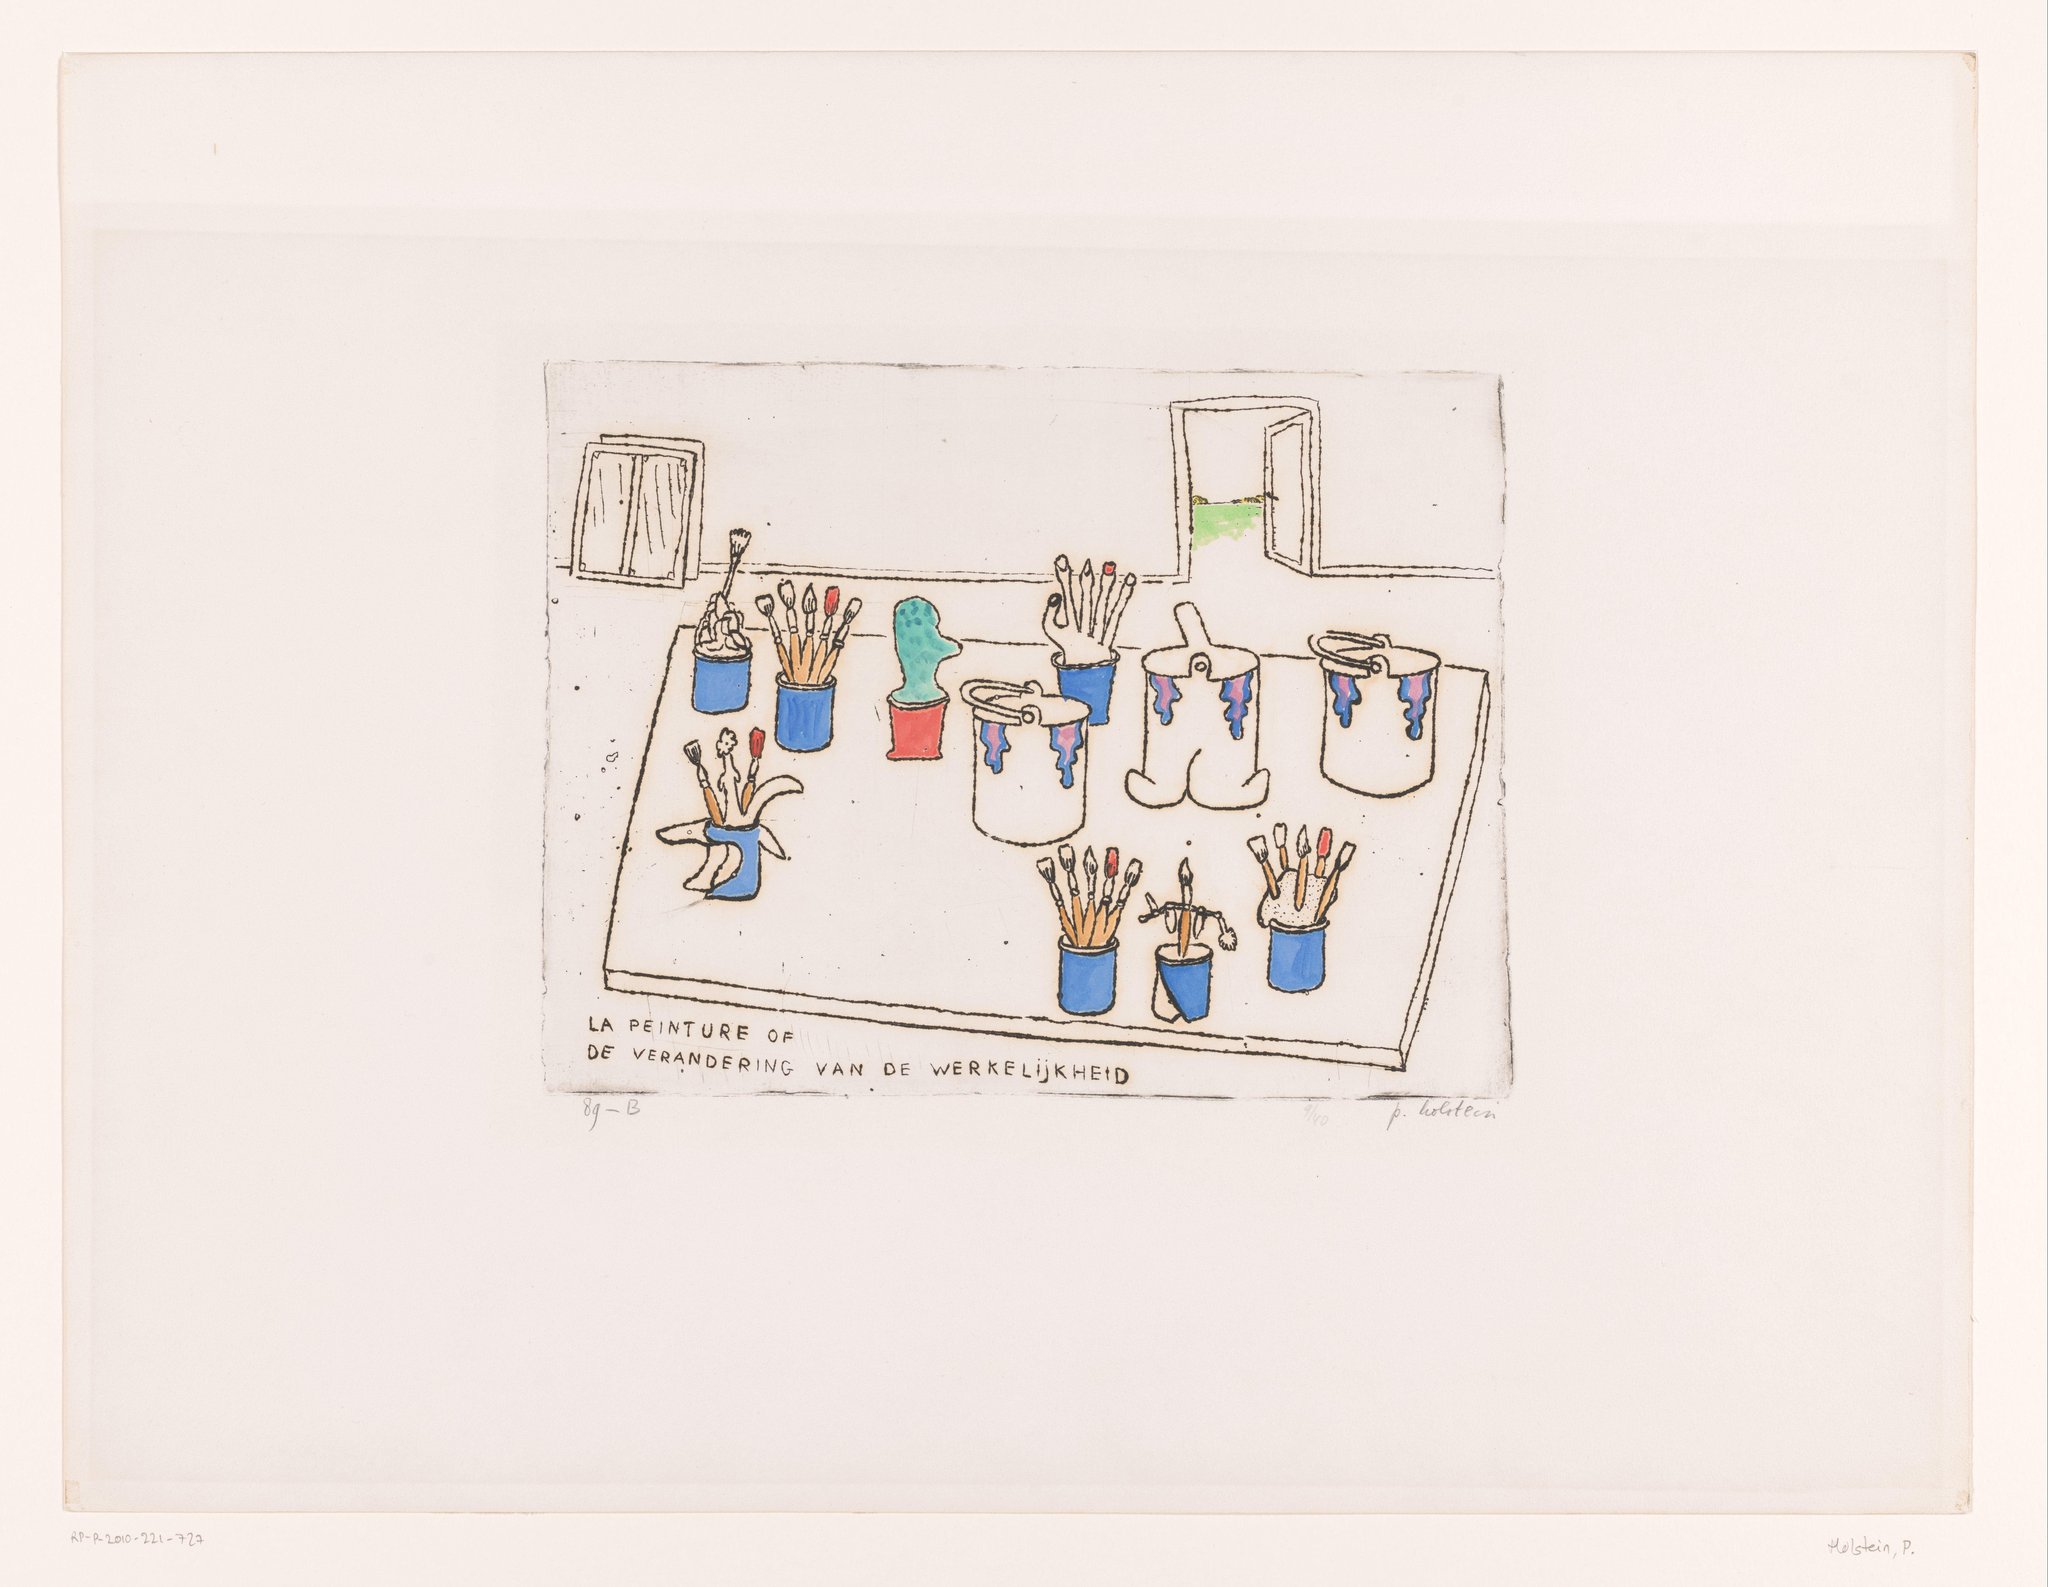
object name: print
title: La peinture of de verandering van de werkelijkheid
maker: pieter holstein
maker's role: draughtsman, painter, print maker, sculptor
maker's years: 1934-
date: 1970-1972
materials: paper, watercolor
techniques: brush, etching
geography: amsterdam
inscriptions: signature: ‘p. holstein’, edition: ‘9/40’, title: ‘LA PEINTURE OF / DE VERANDERING VAN DE WERKELIJKHEID’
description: Potten met kwasten waarvan er een op een hand lijkt.